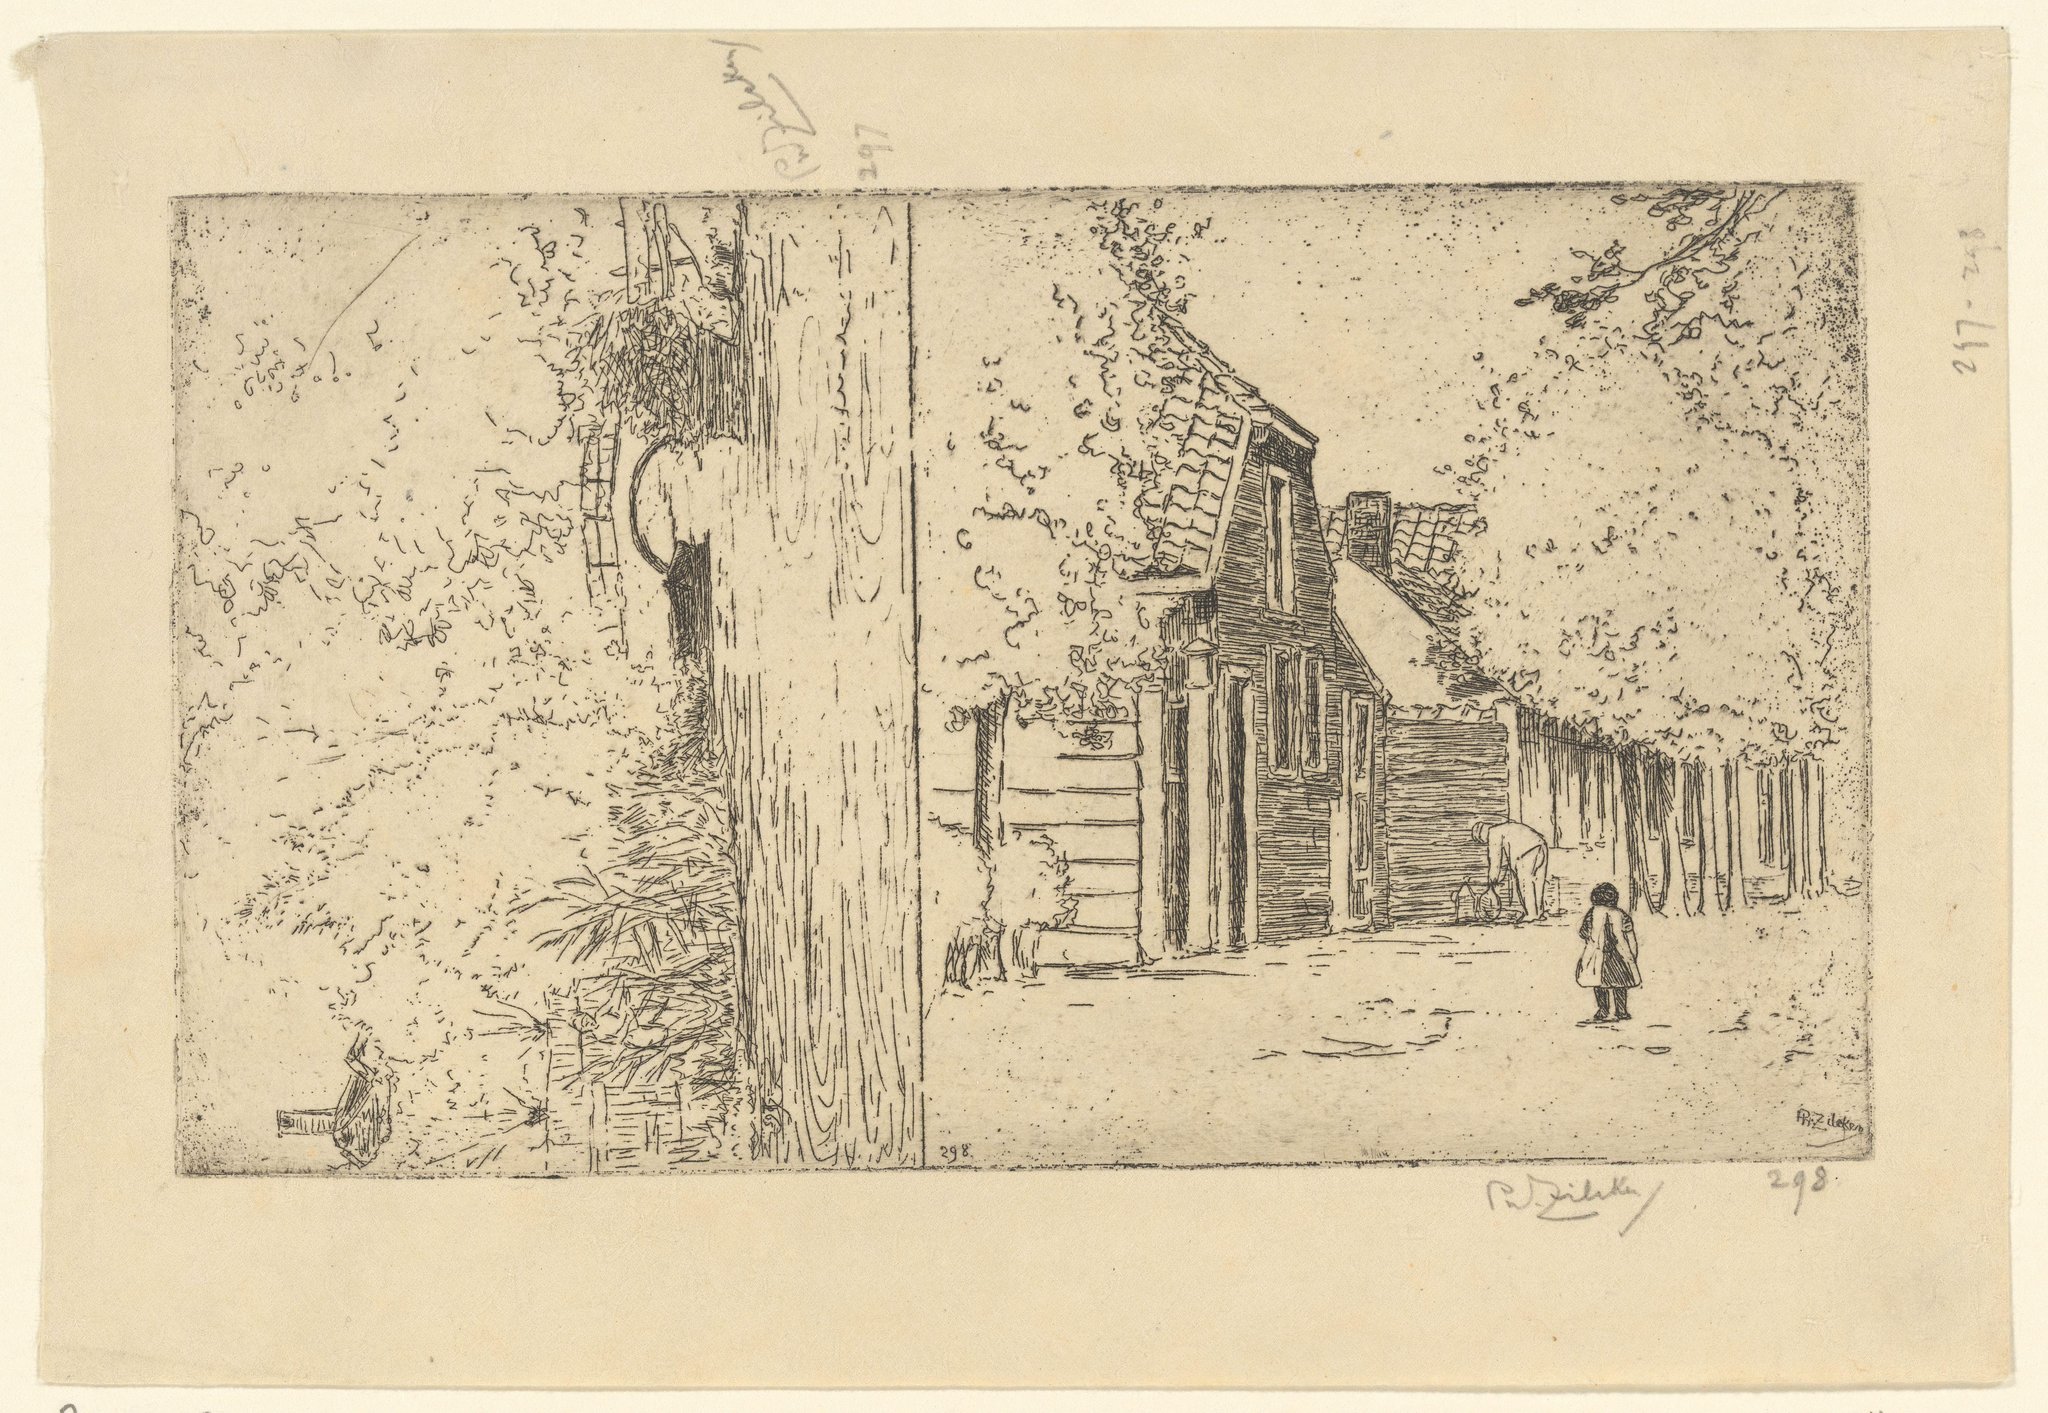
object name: print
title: Pont / L'atelier du charpentier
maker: philip zilcken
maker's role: draughtsman, painter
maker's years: 1857-1930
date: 1890-1930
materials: paper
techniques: etching, intaglio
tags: village street, pond, pool, bridge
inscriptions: collector's mark: Lugt 2760, collector's mark: Lugt 2228